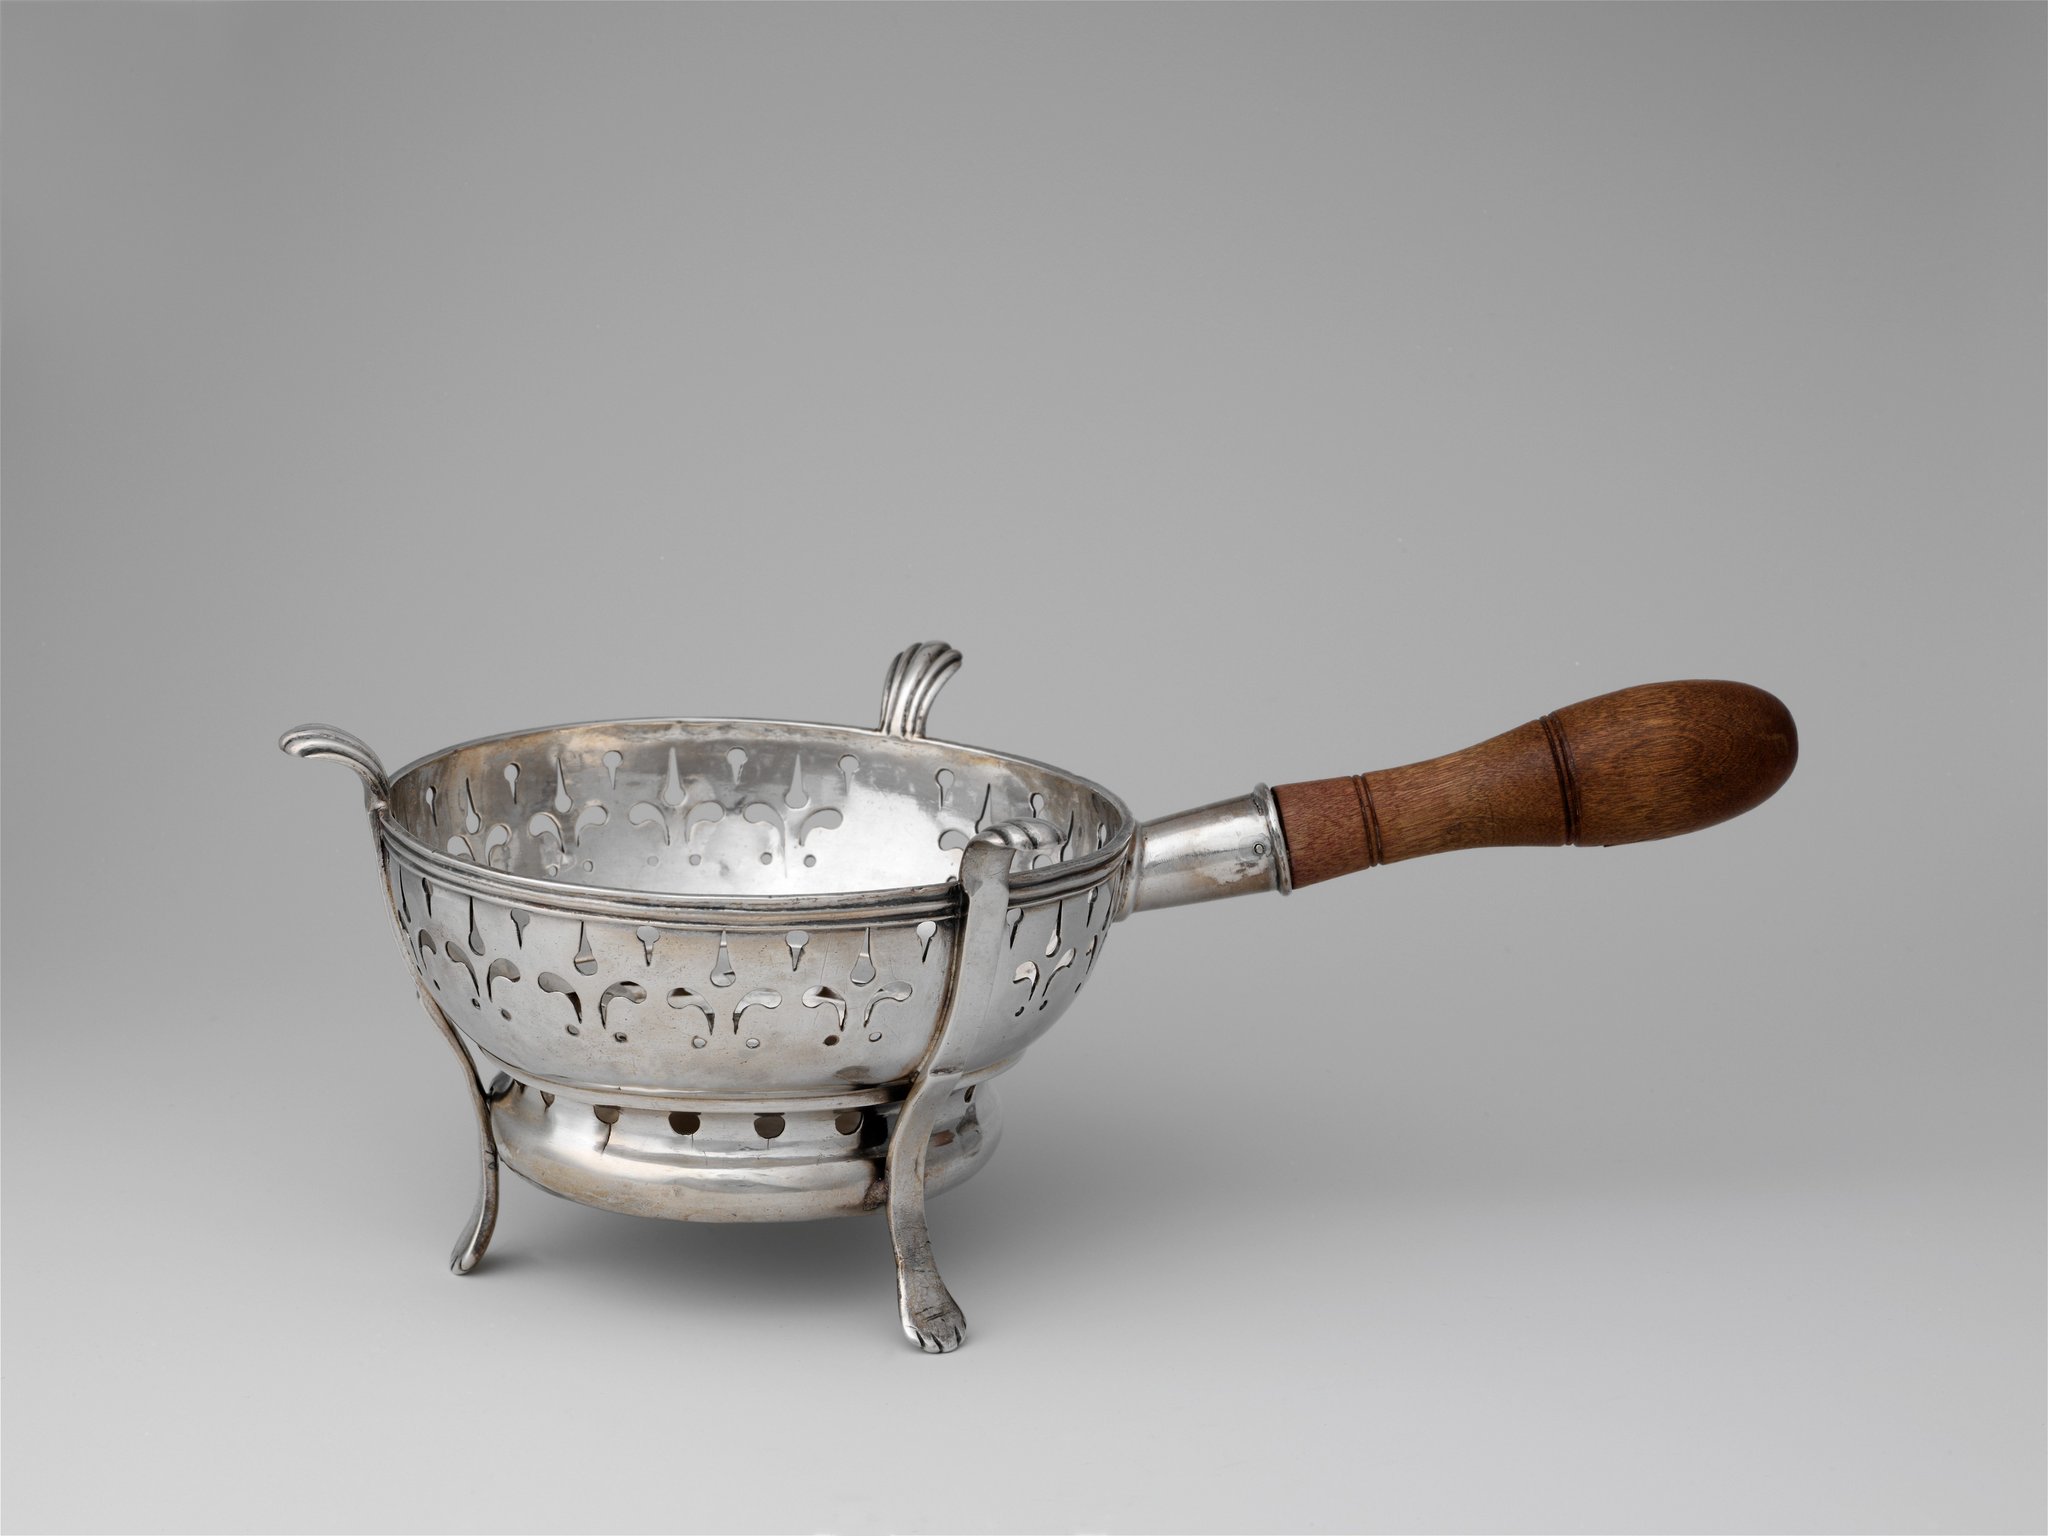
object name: chafing dish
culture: american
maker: peter van dyck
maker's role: maker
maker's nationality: american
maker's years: 1684-1750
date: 1725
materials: silver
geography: united states